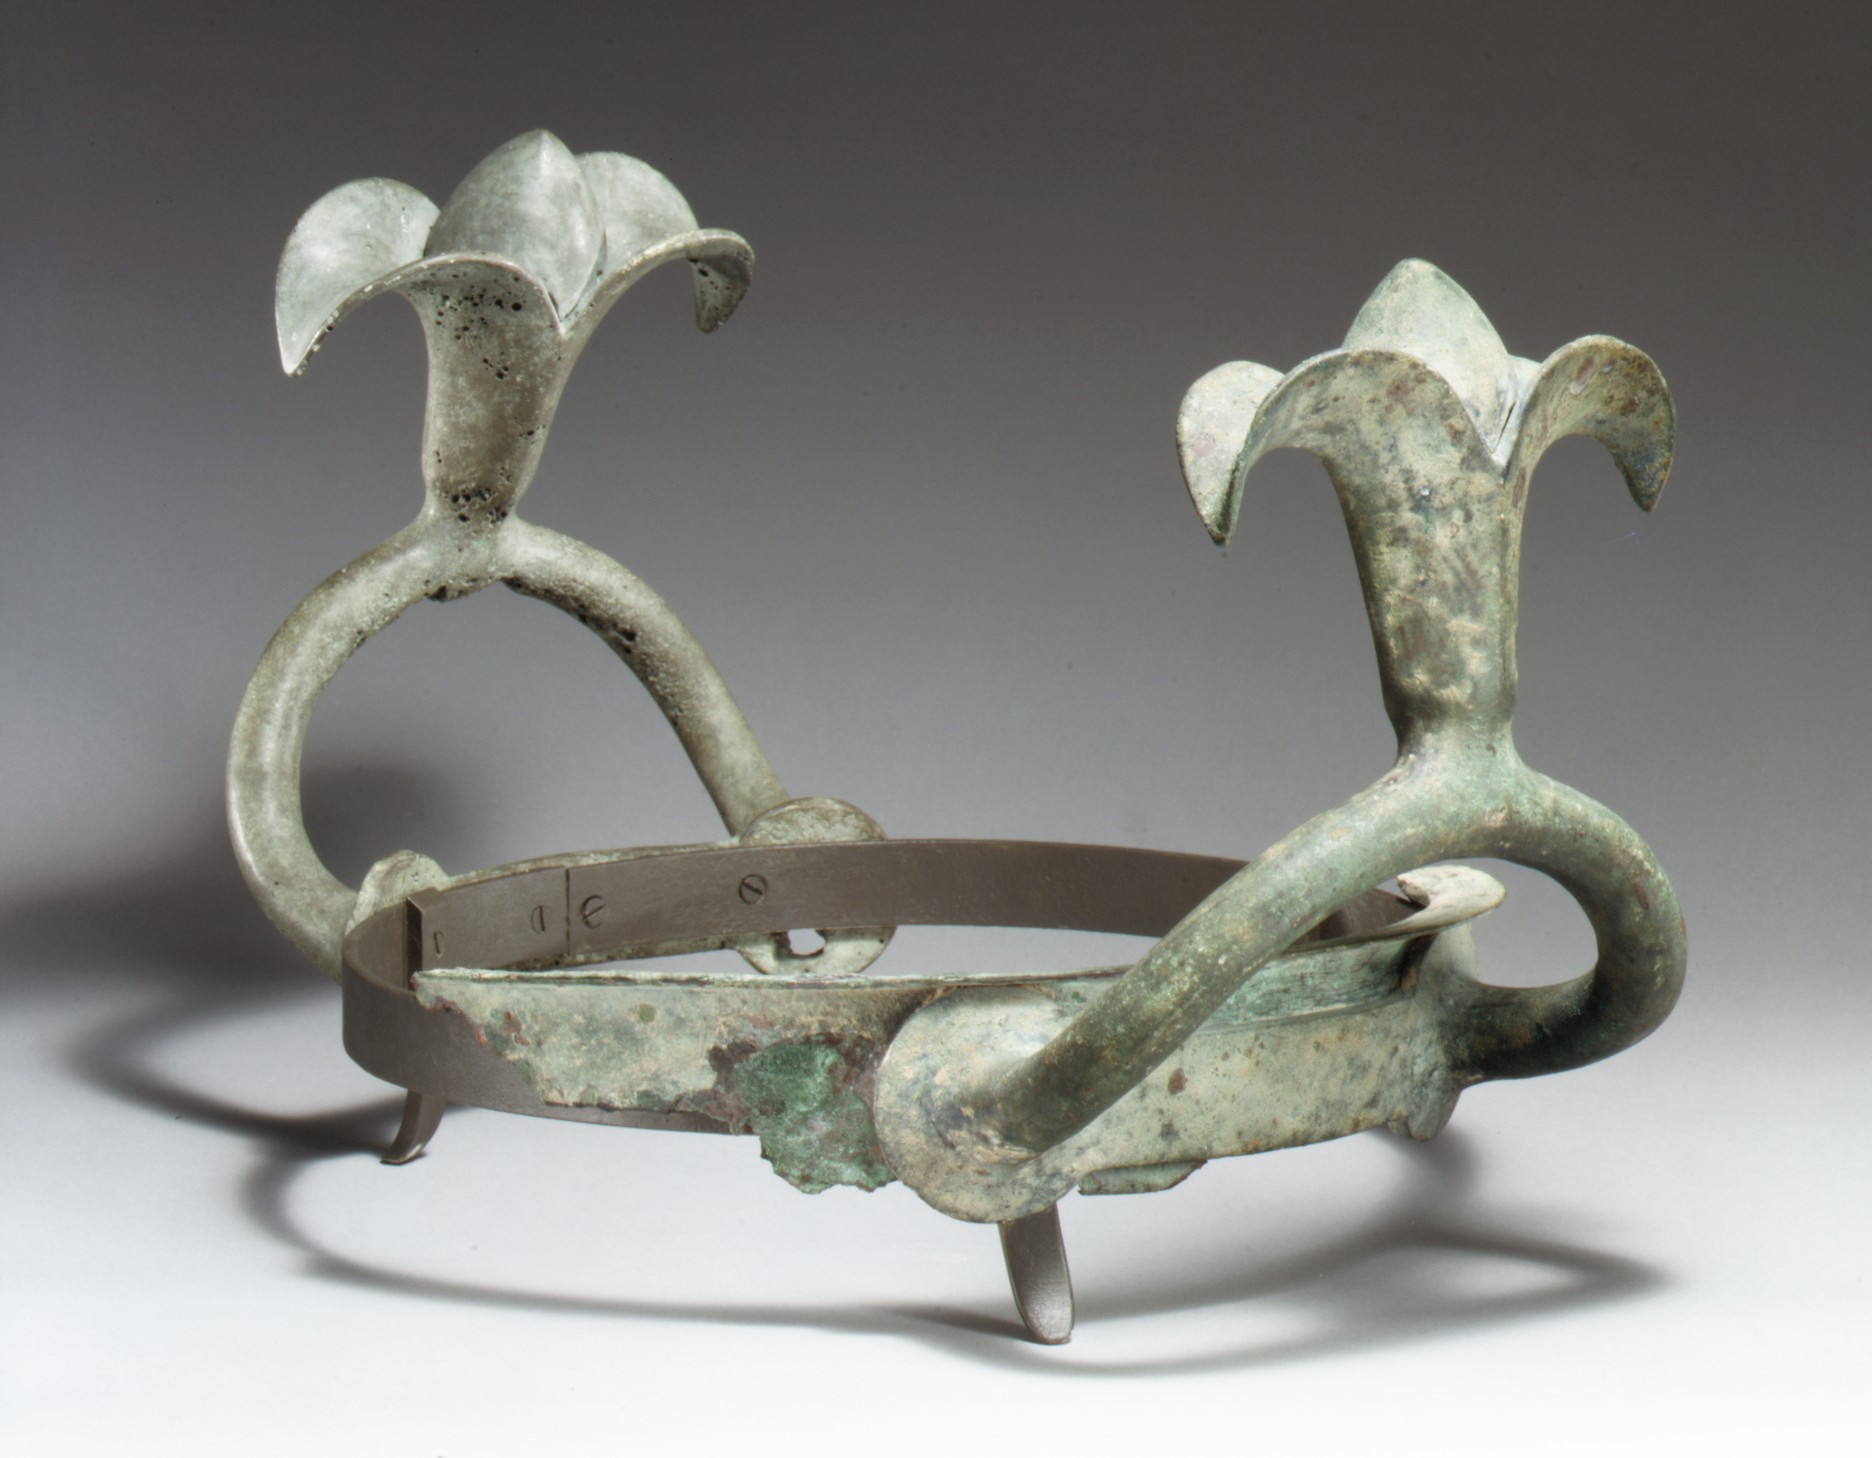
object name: bowl rim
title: Bronze handles and part of the rim of a cauldron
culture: cypriot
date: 850-750 BCE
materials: bronze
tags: flowers